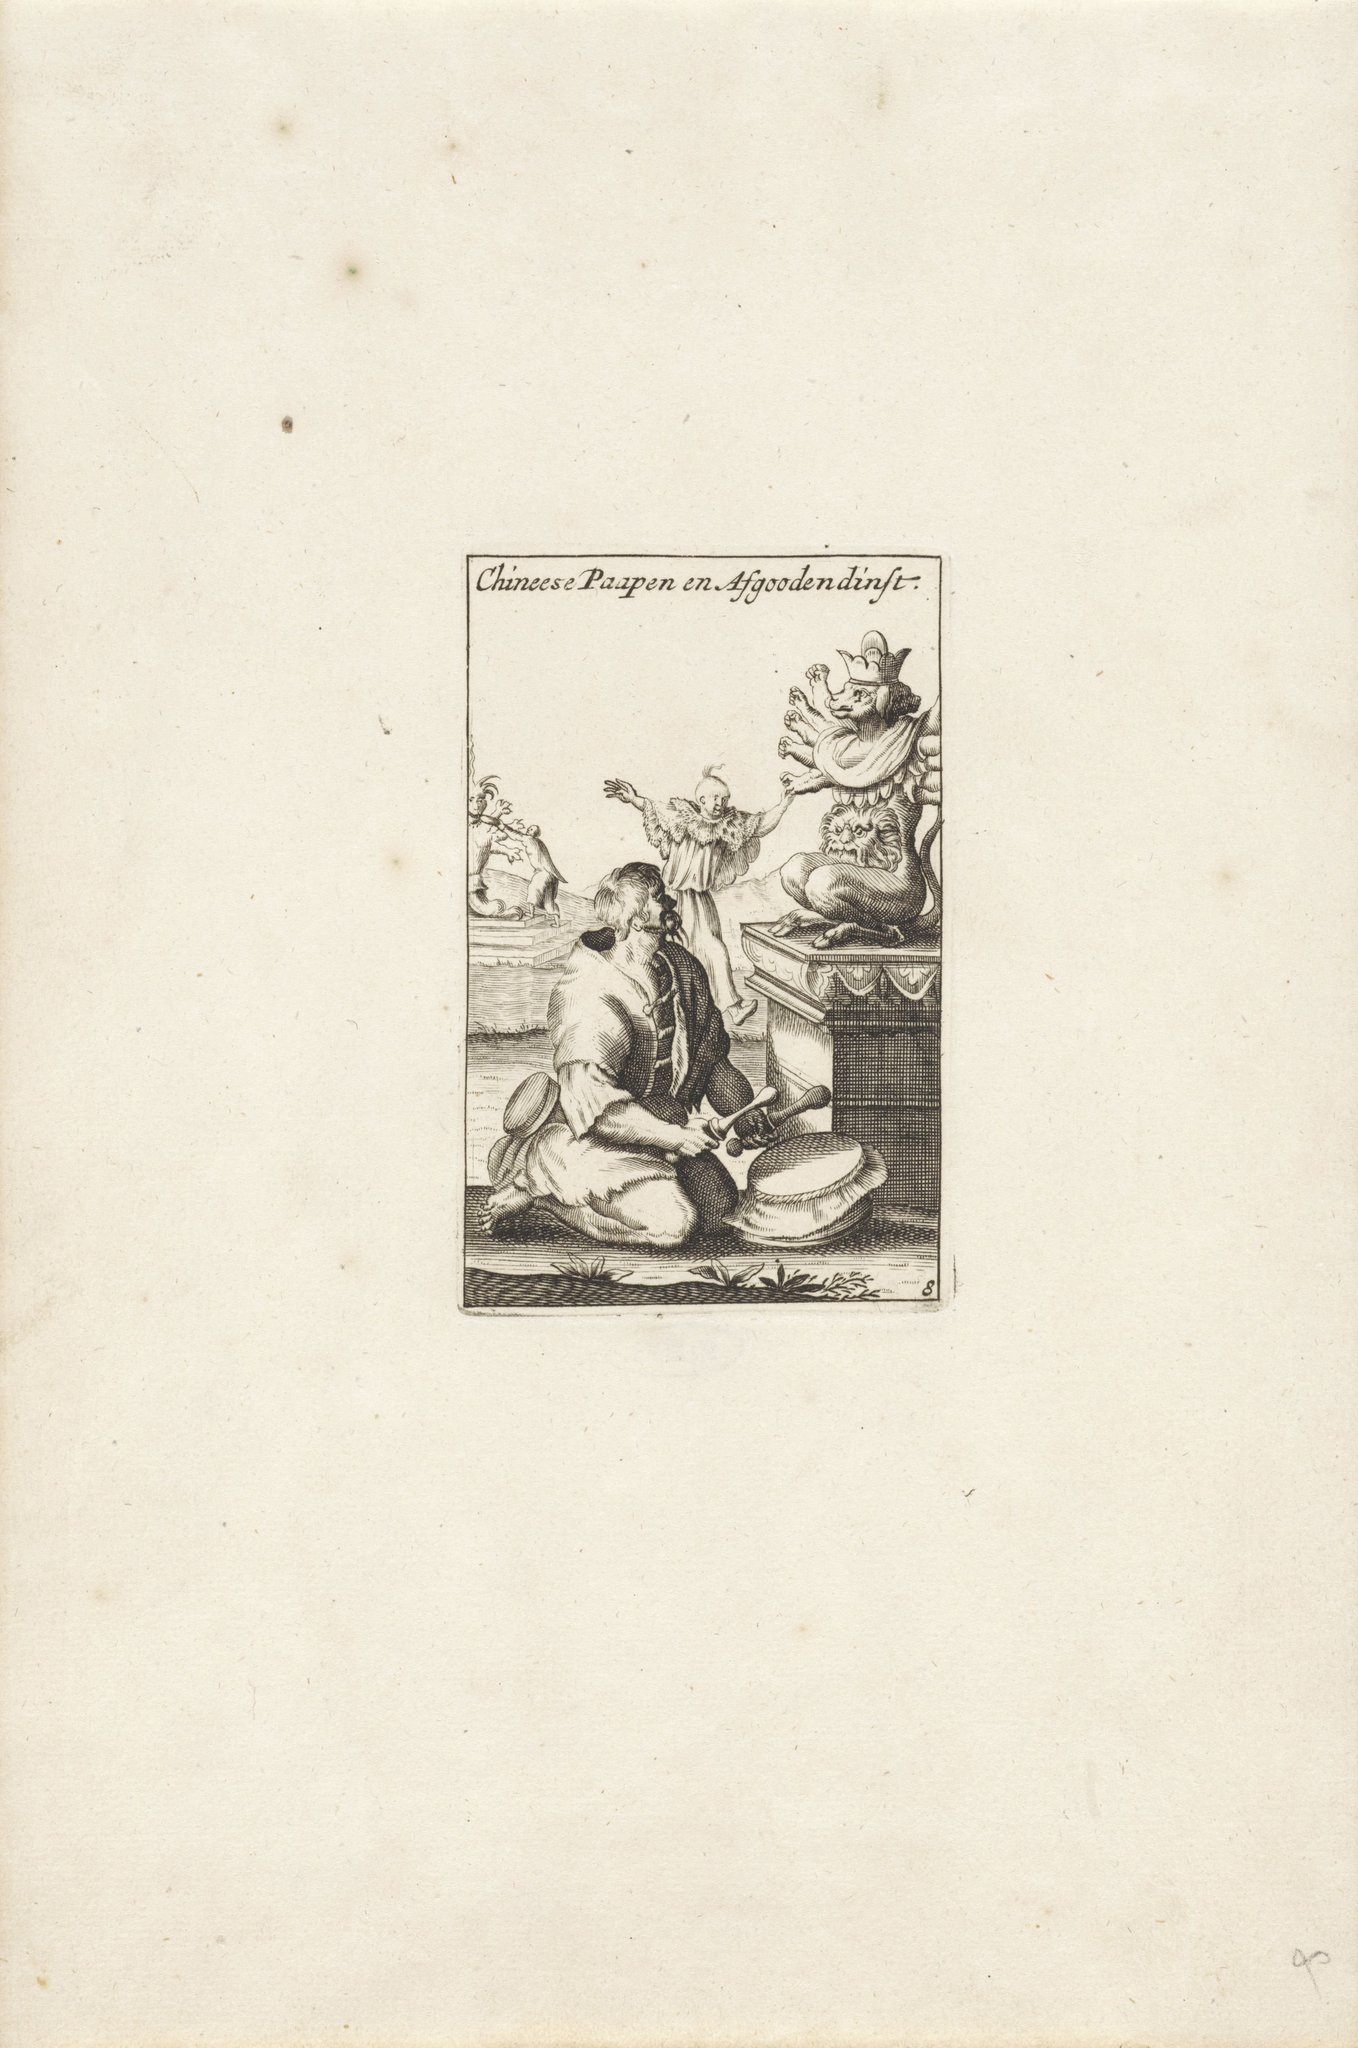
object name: print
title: Chineese en Vremden Nasie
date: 1682-1711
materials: paper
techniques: etching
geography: amsterdam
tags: chinese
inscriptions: collector's mark: Lugt 2228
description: Deze serie bestaat uit kopieën naar de prenten in: Vries, Simon de. Curieuse aenmerckingen der bysonderste Oost en West-Indische verwonderens-waerdige dingen. Utrecht: Johannes Ribbius, 1682.